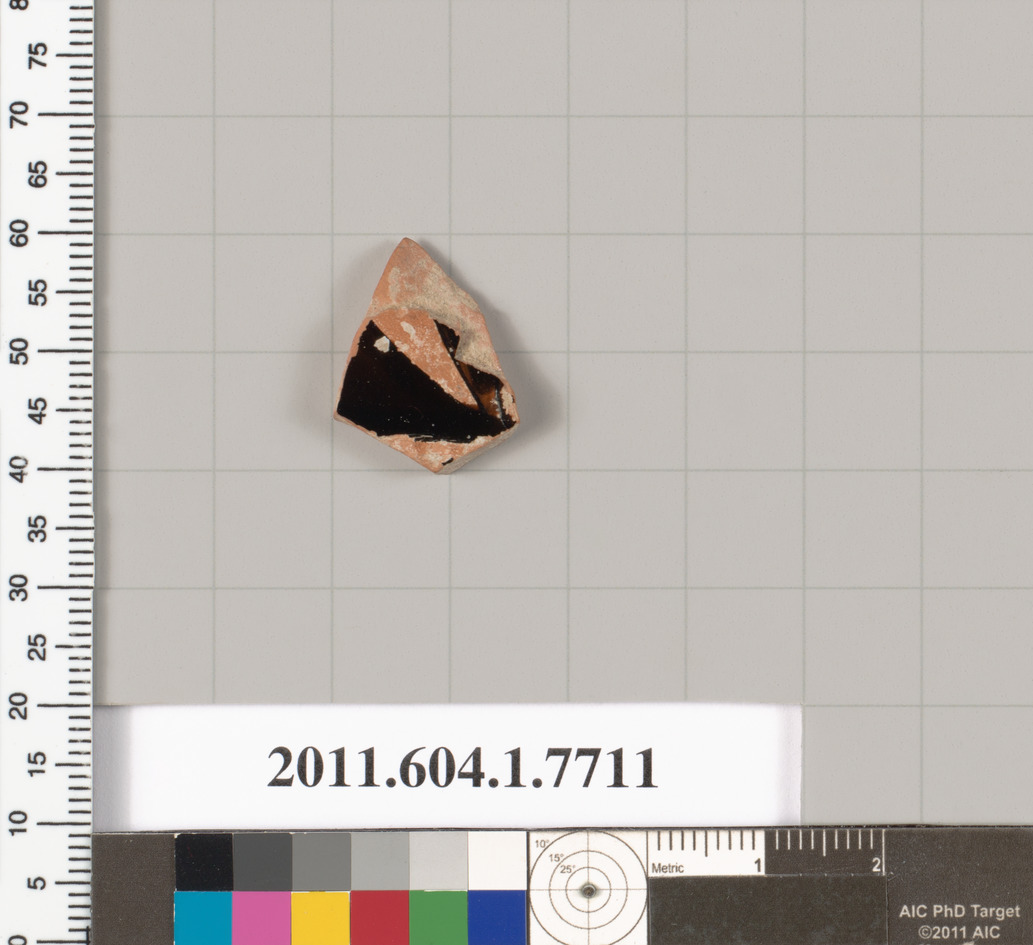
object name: kylix fragment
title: Terracotta fragment of a kylix (drinking cup)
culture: greek, attic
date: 460-450 BCE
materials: terracotta